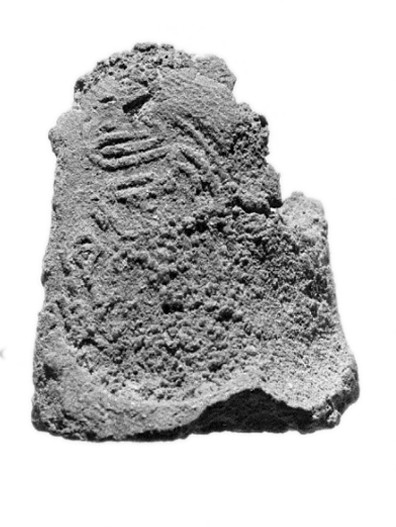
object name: sealing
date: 1981-1640 BCE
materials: mud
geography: egypt